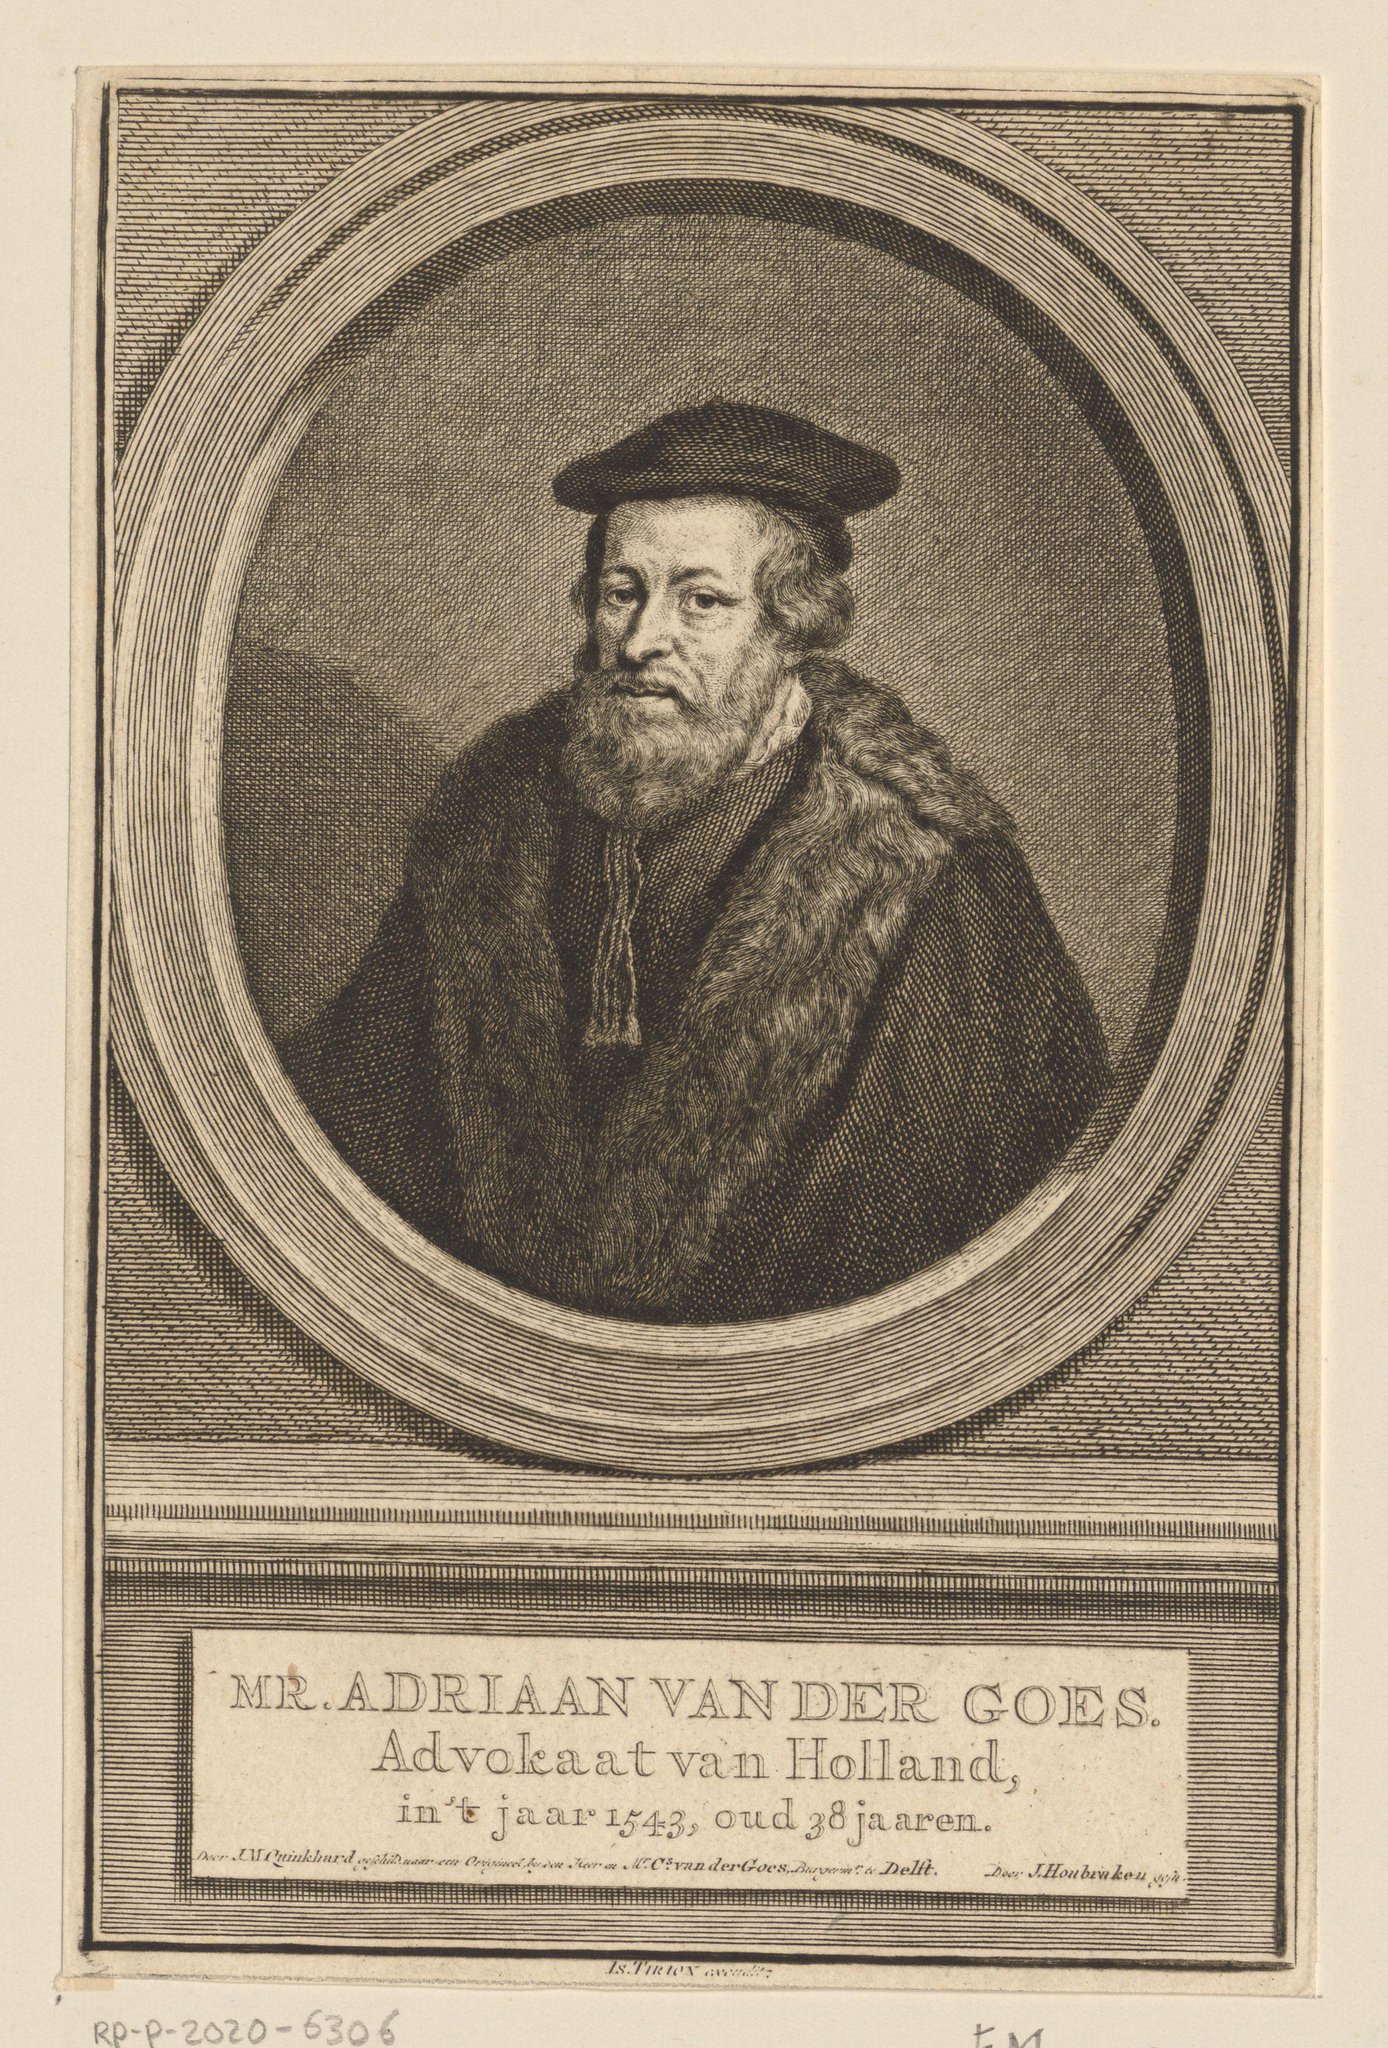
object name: print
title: Portret van Adriaan van der Goes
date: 1749-1759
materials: paper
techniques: engraving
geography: amsterdam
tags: delft, commander-in-chief, general, marshal, historical persons, lawyer, attorney at law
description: Prent uit: Wagenaar, Jan. Vaderlandsche historie, vervattende de geschiedenissen der nu Vereenigde Nederlanden, inzonderheid die van Holland (...). 21 dln. Amsterdam: Isaak Tirion, [1749-1759].